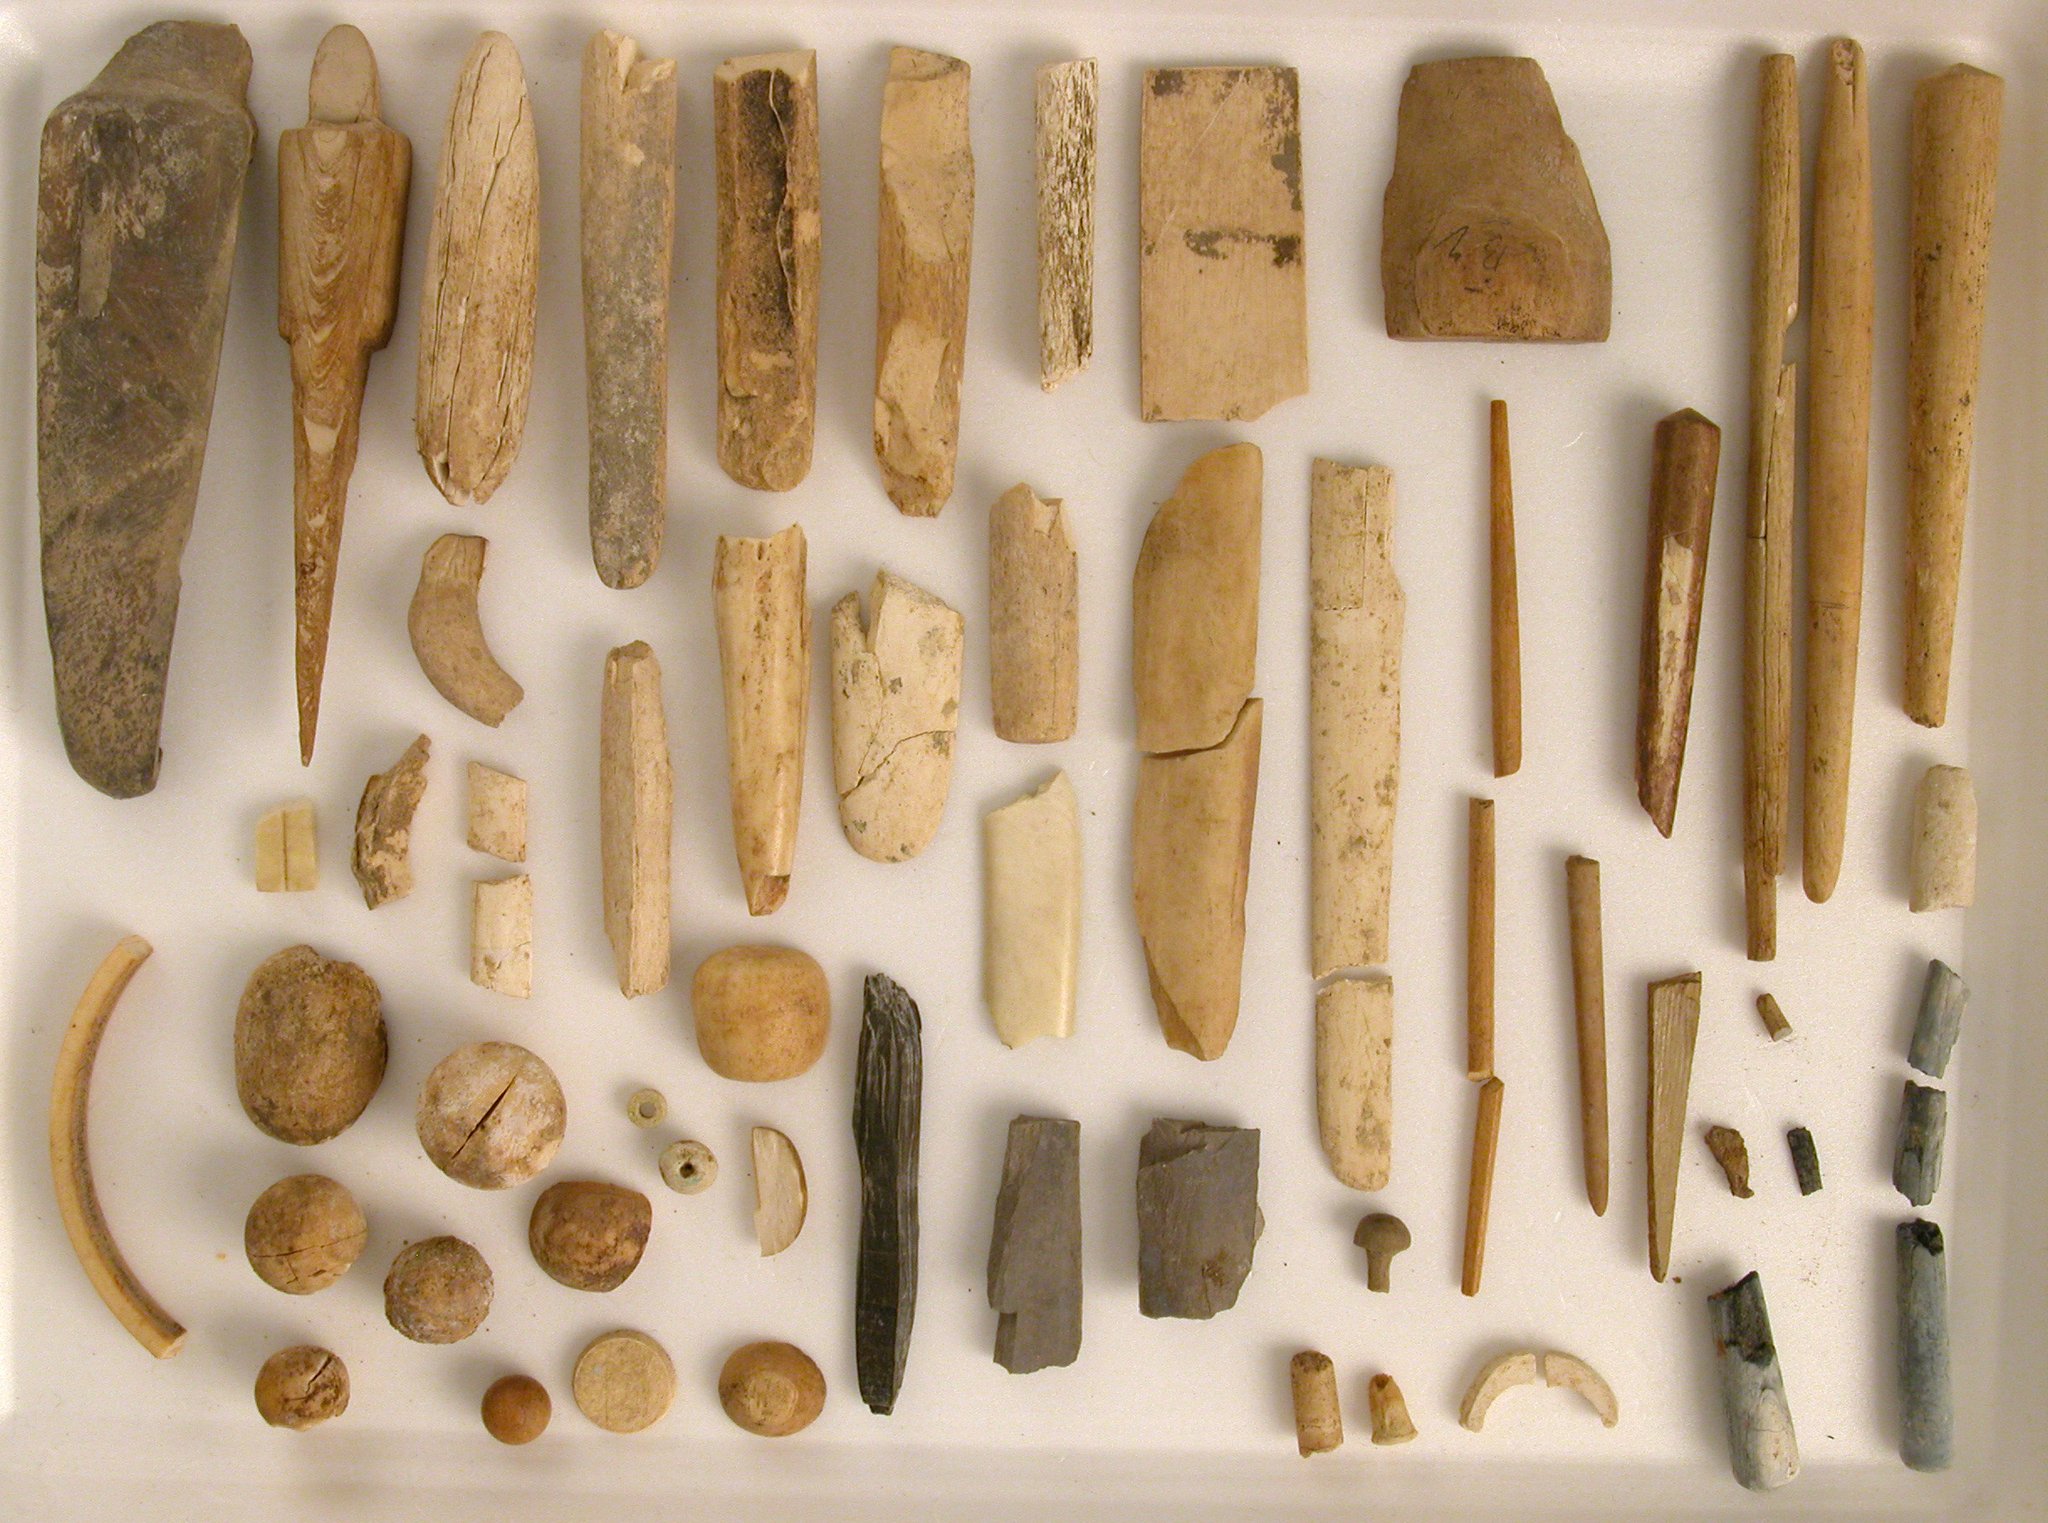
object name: fragment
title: Ivory Fragments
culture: coptic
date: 301-700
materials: glass, ivory, wood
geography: egypt